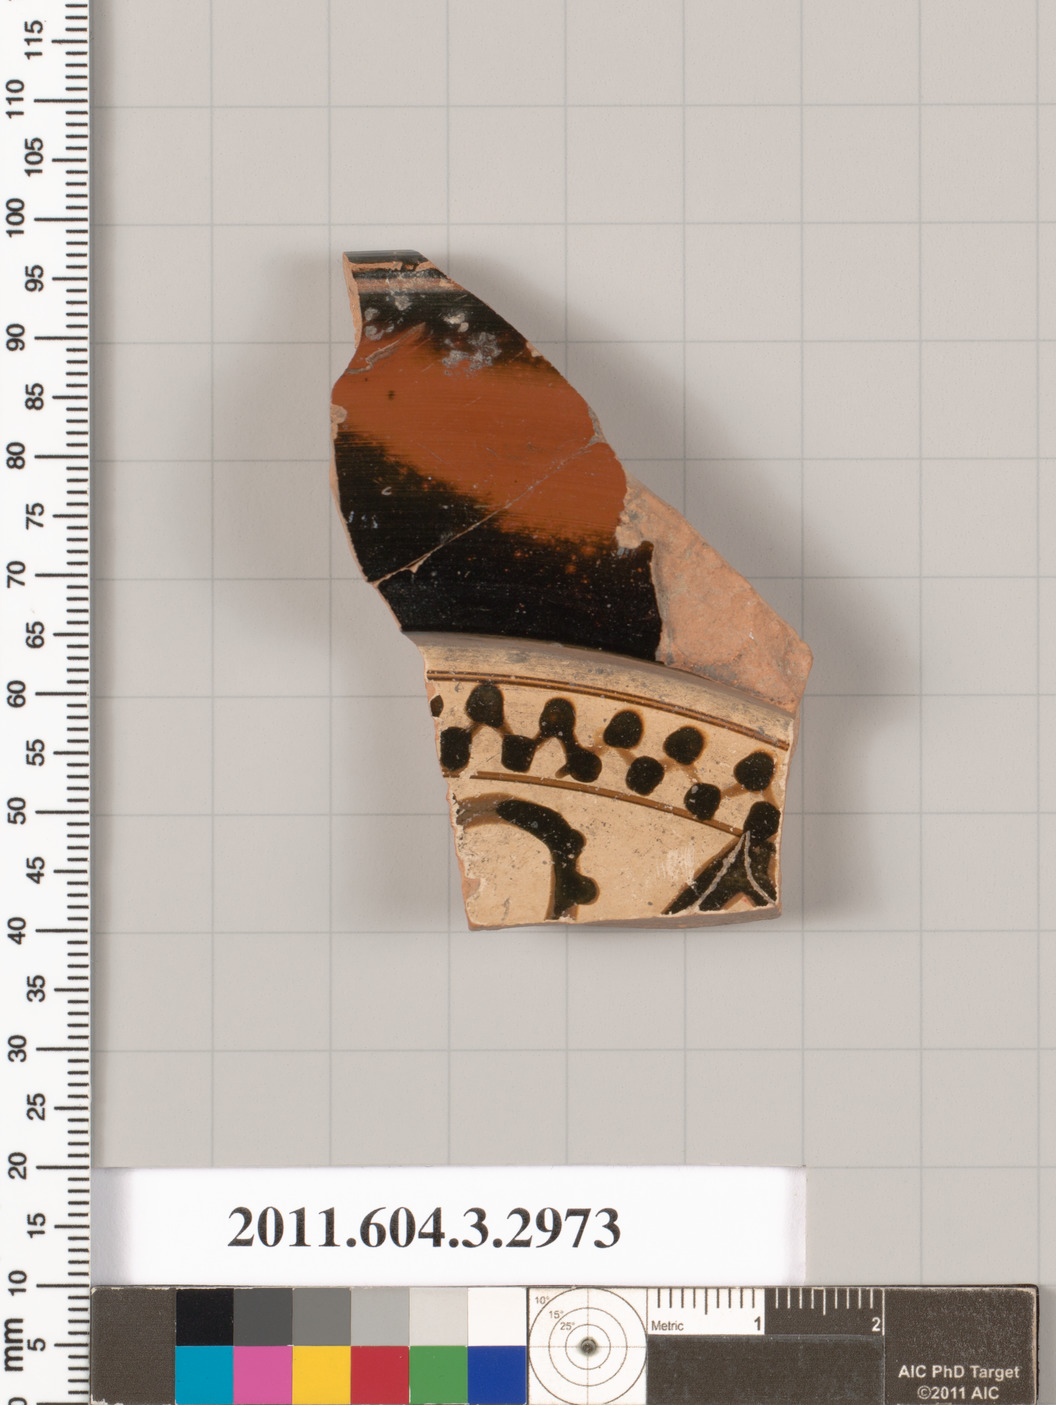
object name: plate fragment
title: Terracotta fragment of a plate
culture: greek, attic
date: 490-480 BCE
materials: terracotta